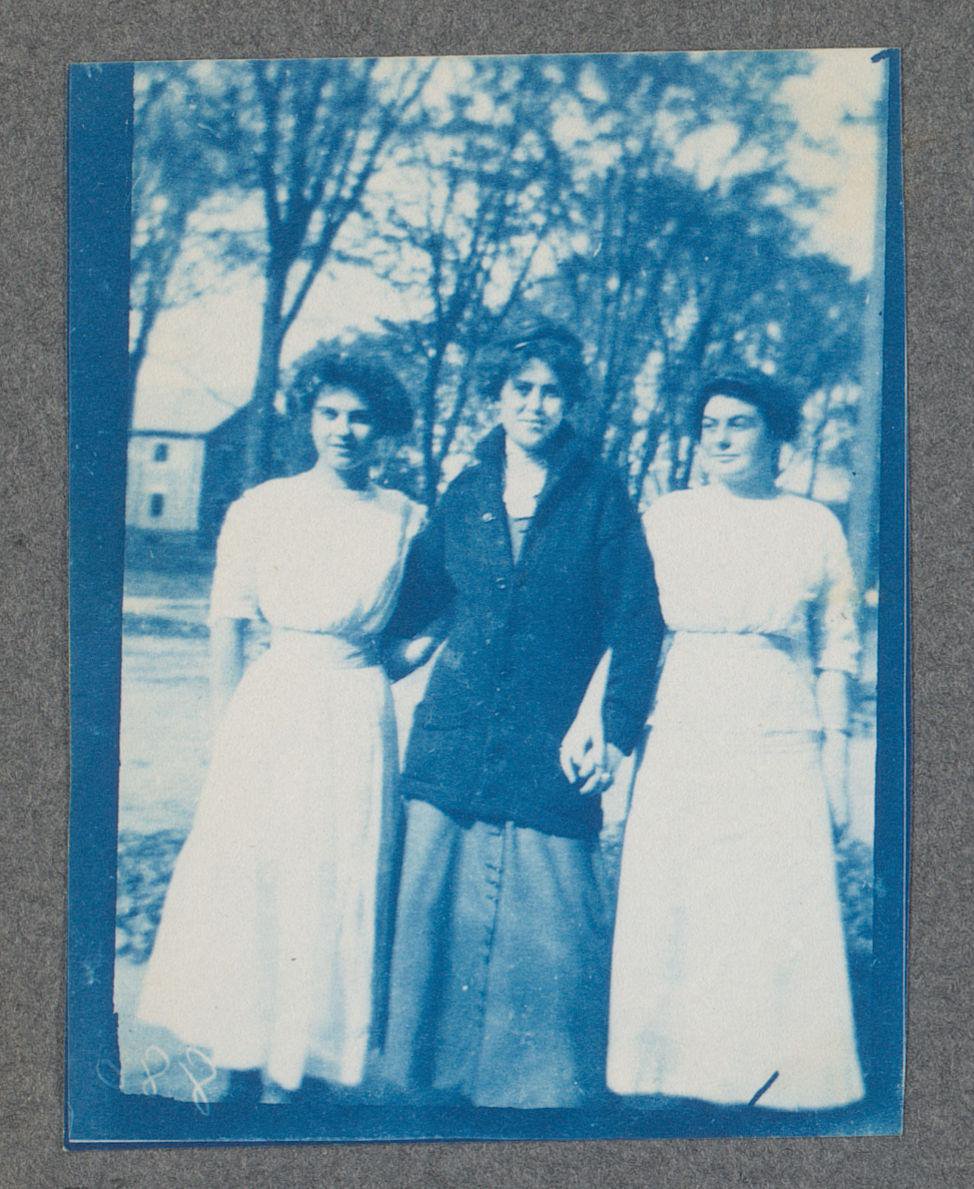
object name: photograph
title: Drie jonge vrouwen, mogelijk op de schoolcampus van St. Johnsbury Academy in Vermont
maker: Anonymous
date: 1905-1915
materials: paper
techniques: cyanotype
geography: st. johnsbury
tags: student - bb - female student